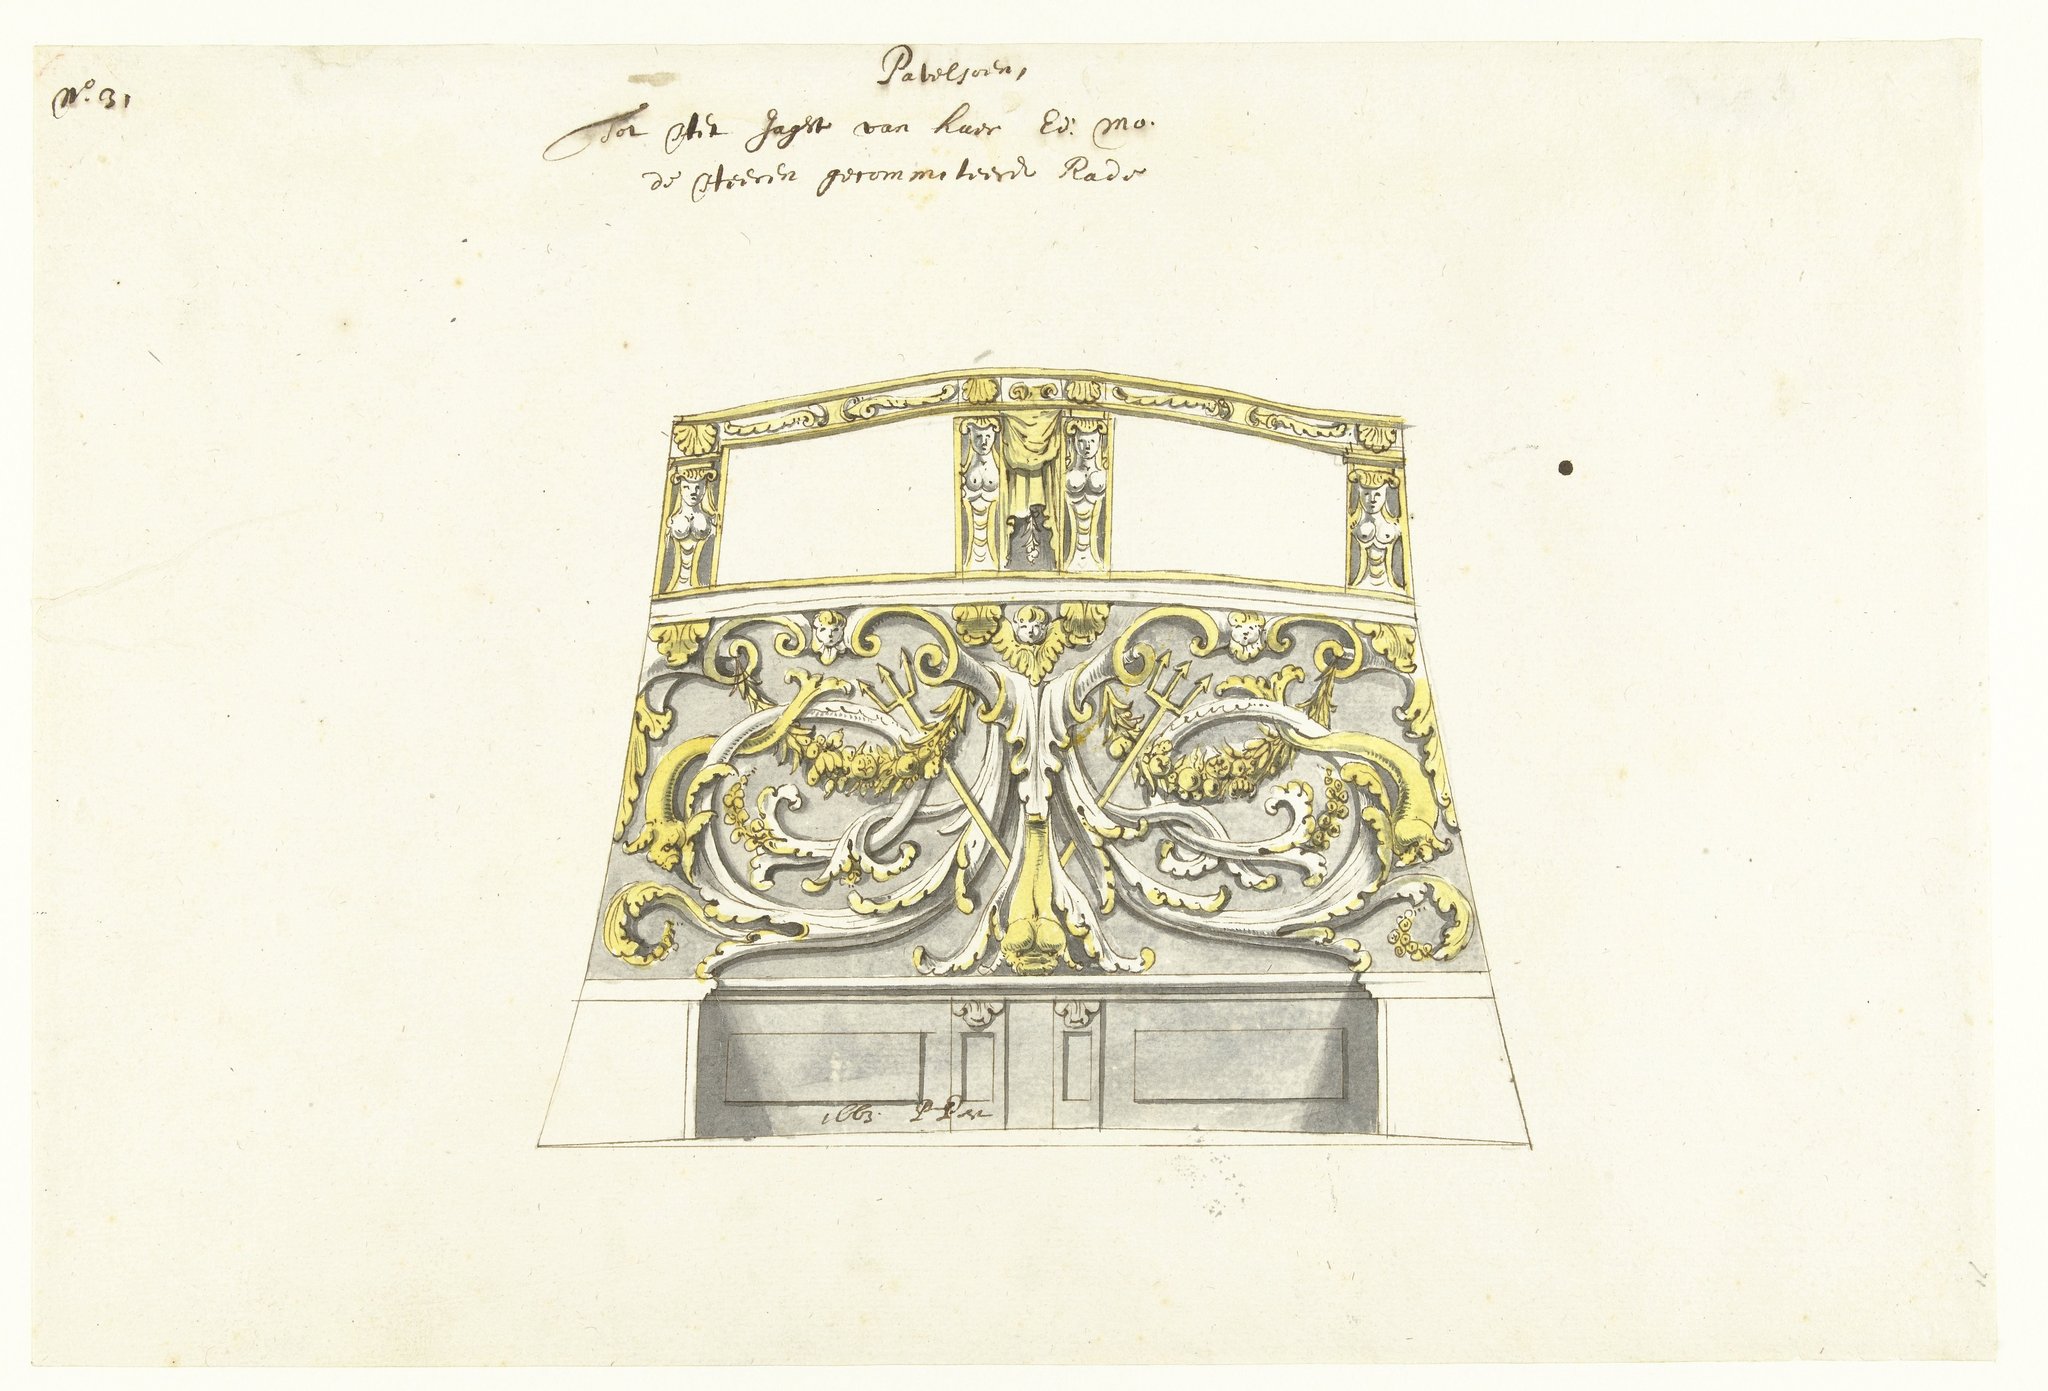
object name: design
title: Interieurdecoratie van statenjacht met twee drietanden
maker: pieter jansz. post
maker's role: draughtsman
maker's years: 1608-1669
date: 1663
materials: ink, paper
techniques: brush, pen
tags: anthropomorphic ornament, parts of ship's interior, attributes of neptune: trident, wall-covering, ornament derived from plant forms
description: Ontwerpen voor decoraties van het interieur van het statenjacht van de Gecommitteerde Raden van Holland: paviljoen, kopwand met decoratie waarin twee drietanden.